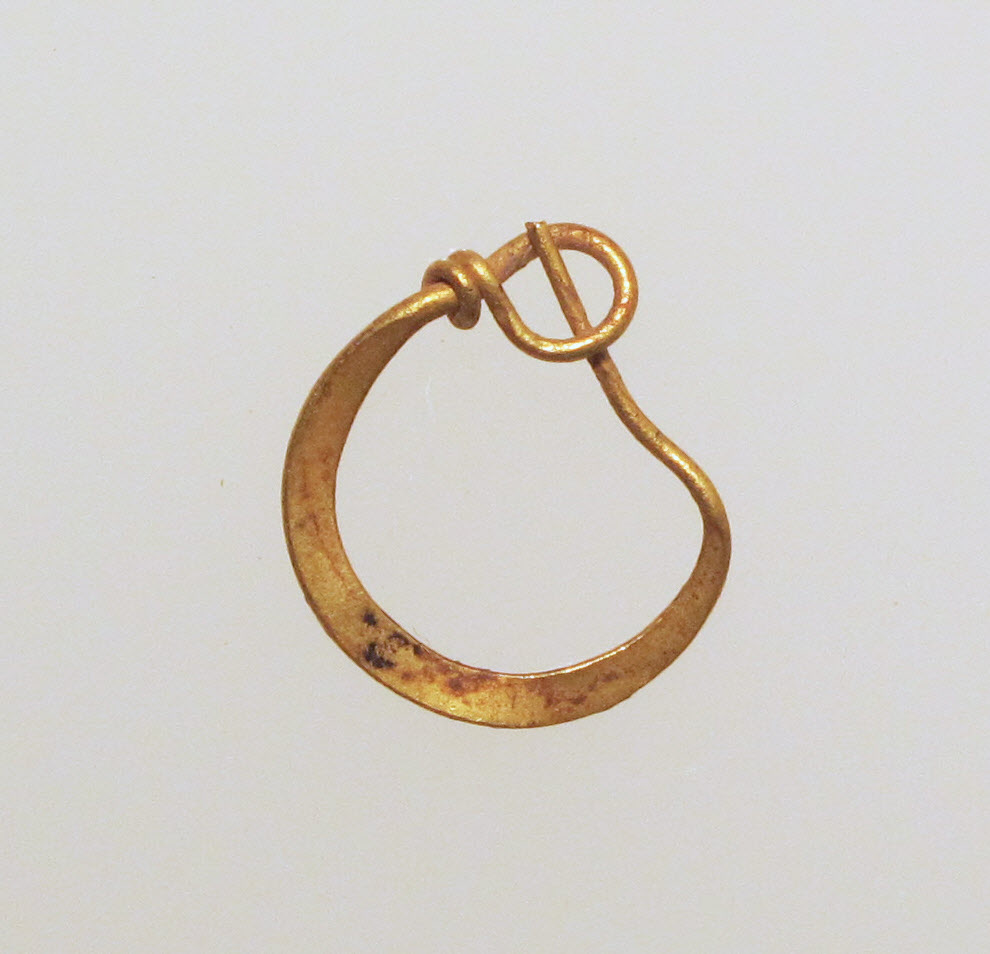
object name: earring, crescent shaped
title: Earring, crescent-shaped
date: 7000 BCE-330 CE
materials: gold